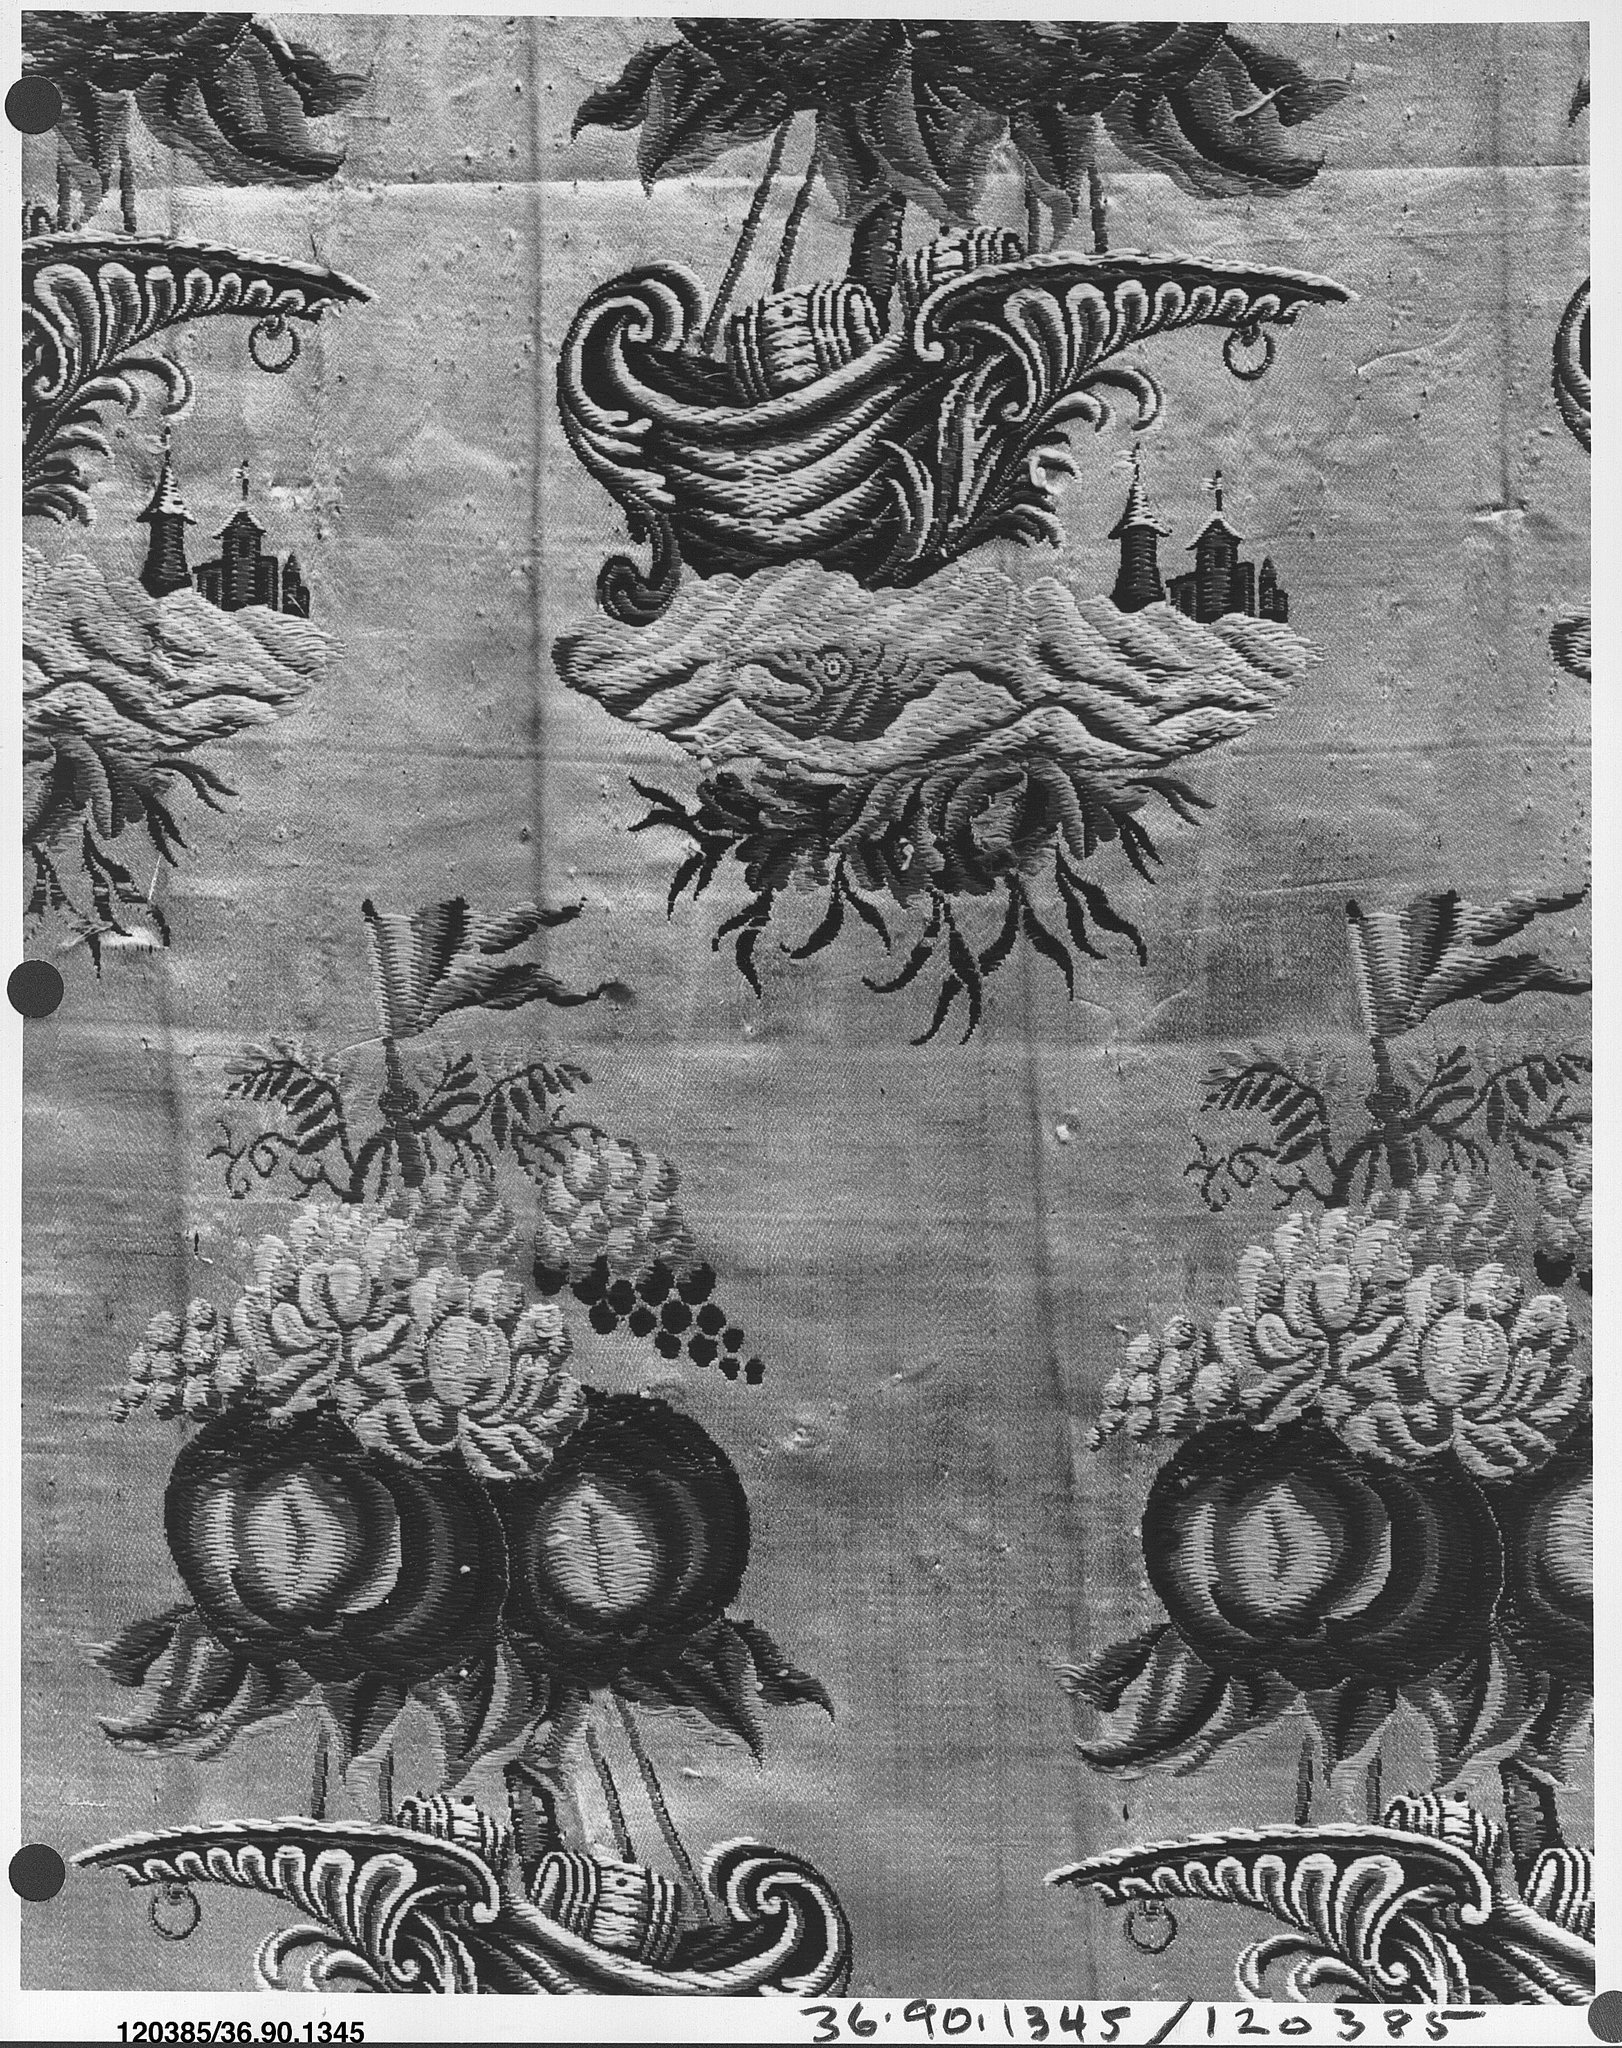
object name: piece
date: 1735-1740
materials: silk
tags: houses,fruit,flowers,boats